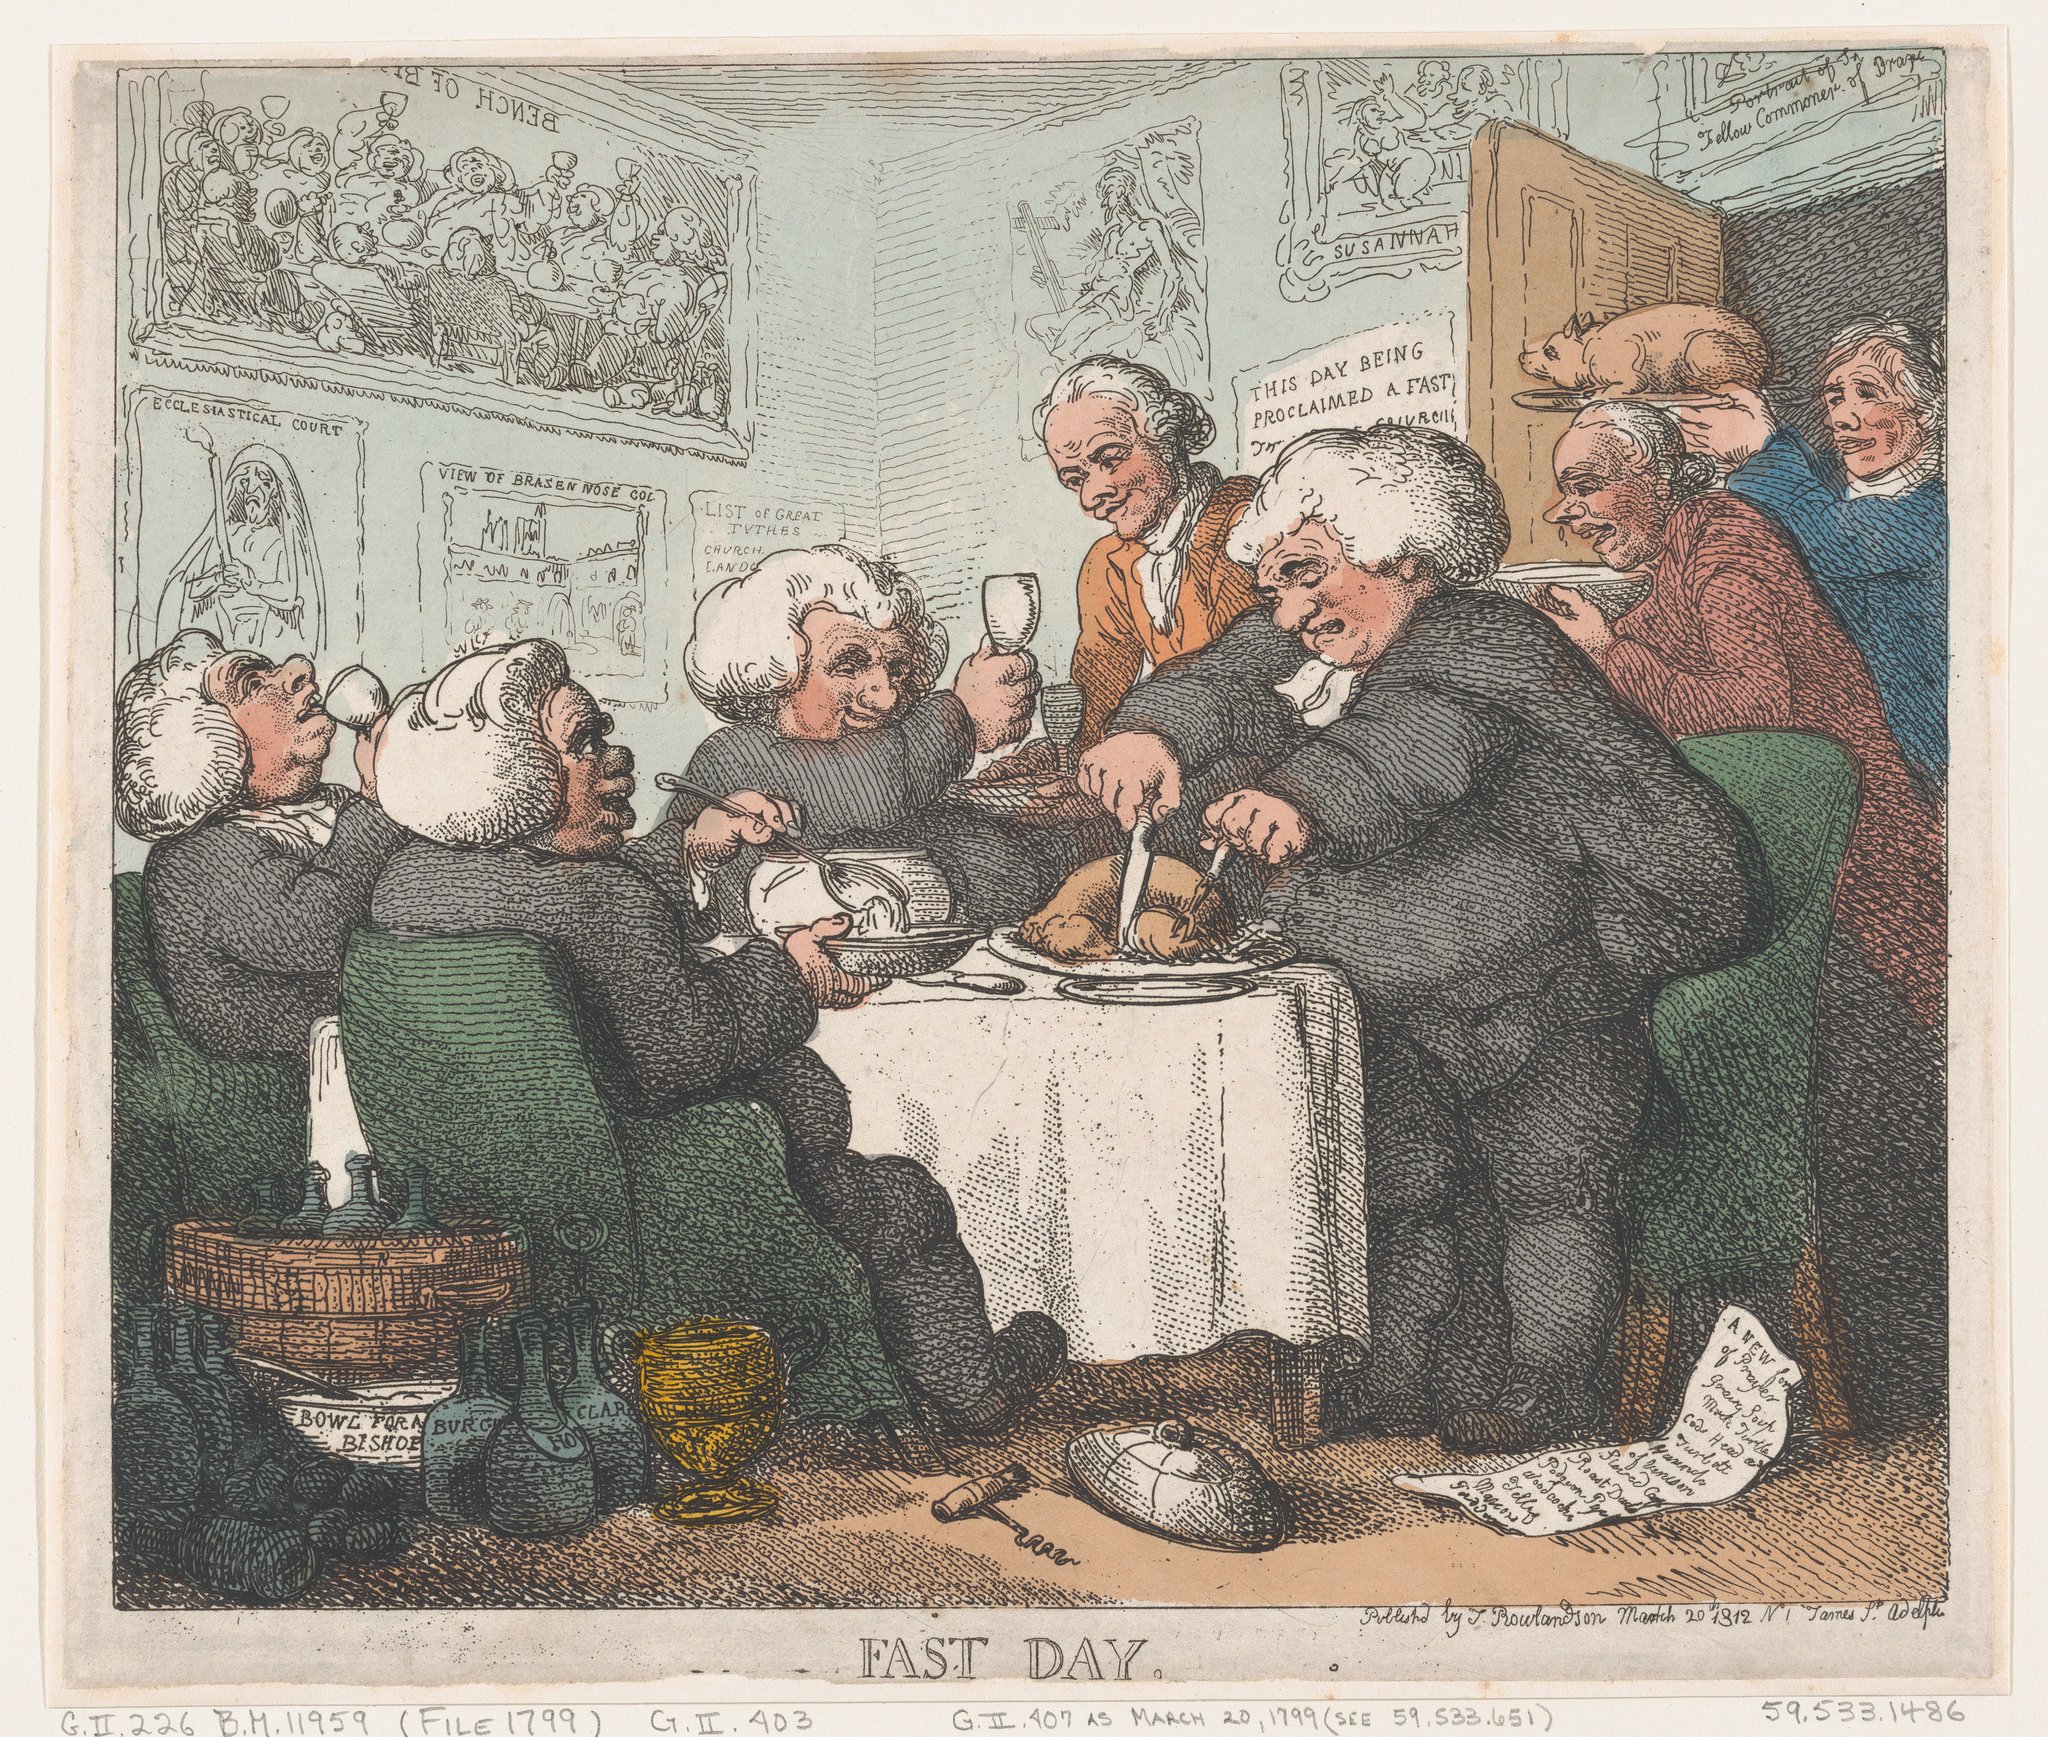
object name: print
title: Fast Day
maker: thomas rowlandson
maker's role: artist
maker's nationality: british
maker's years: 1757-1827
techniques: etching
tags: food,satire,men,pigs,drinking